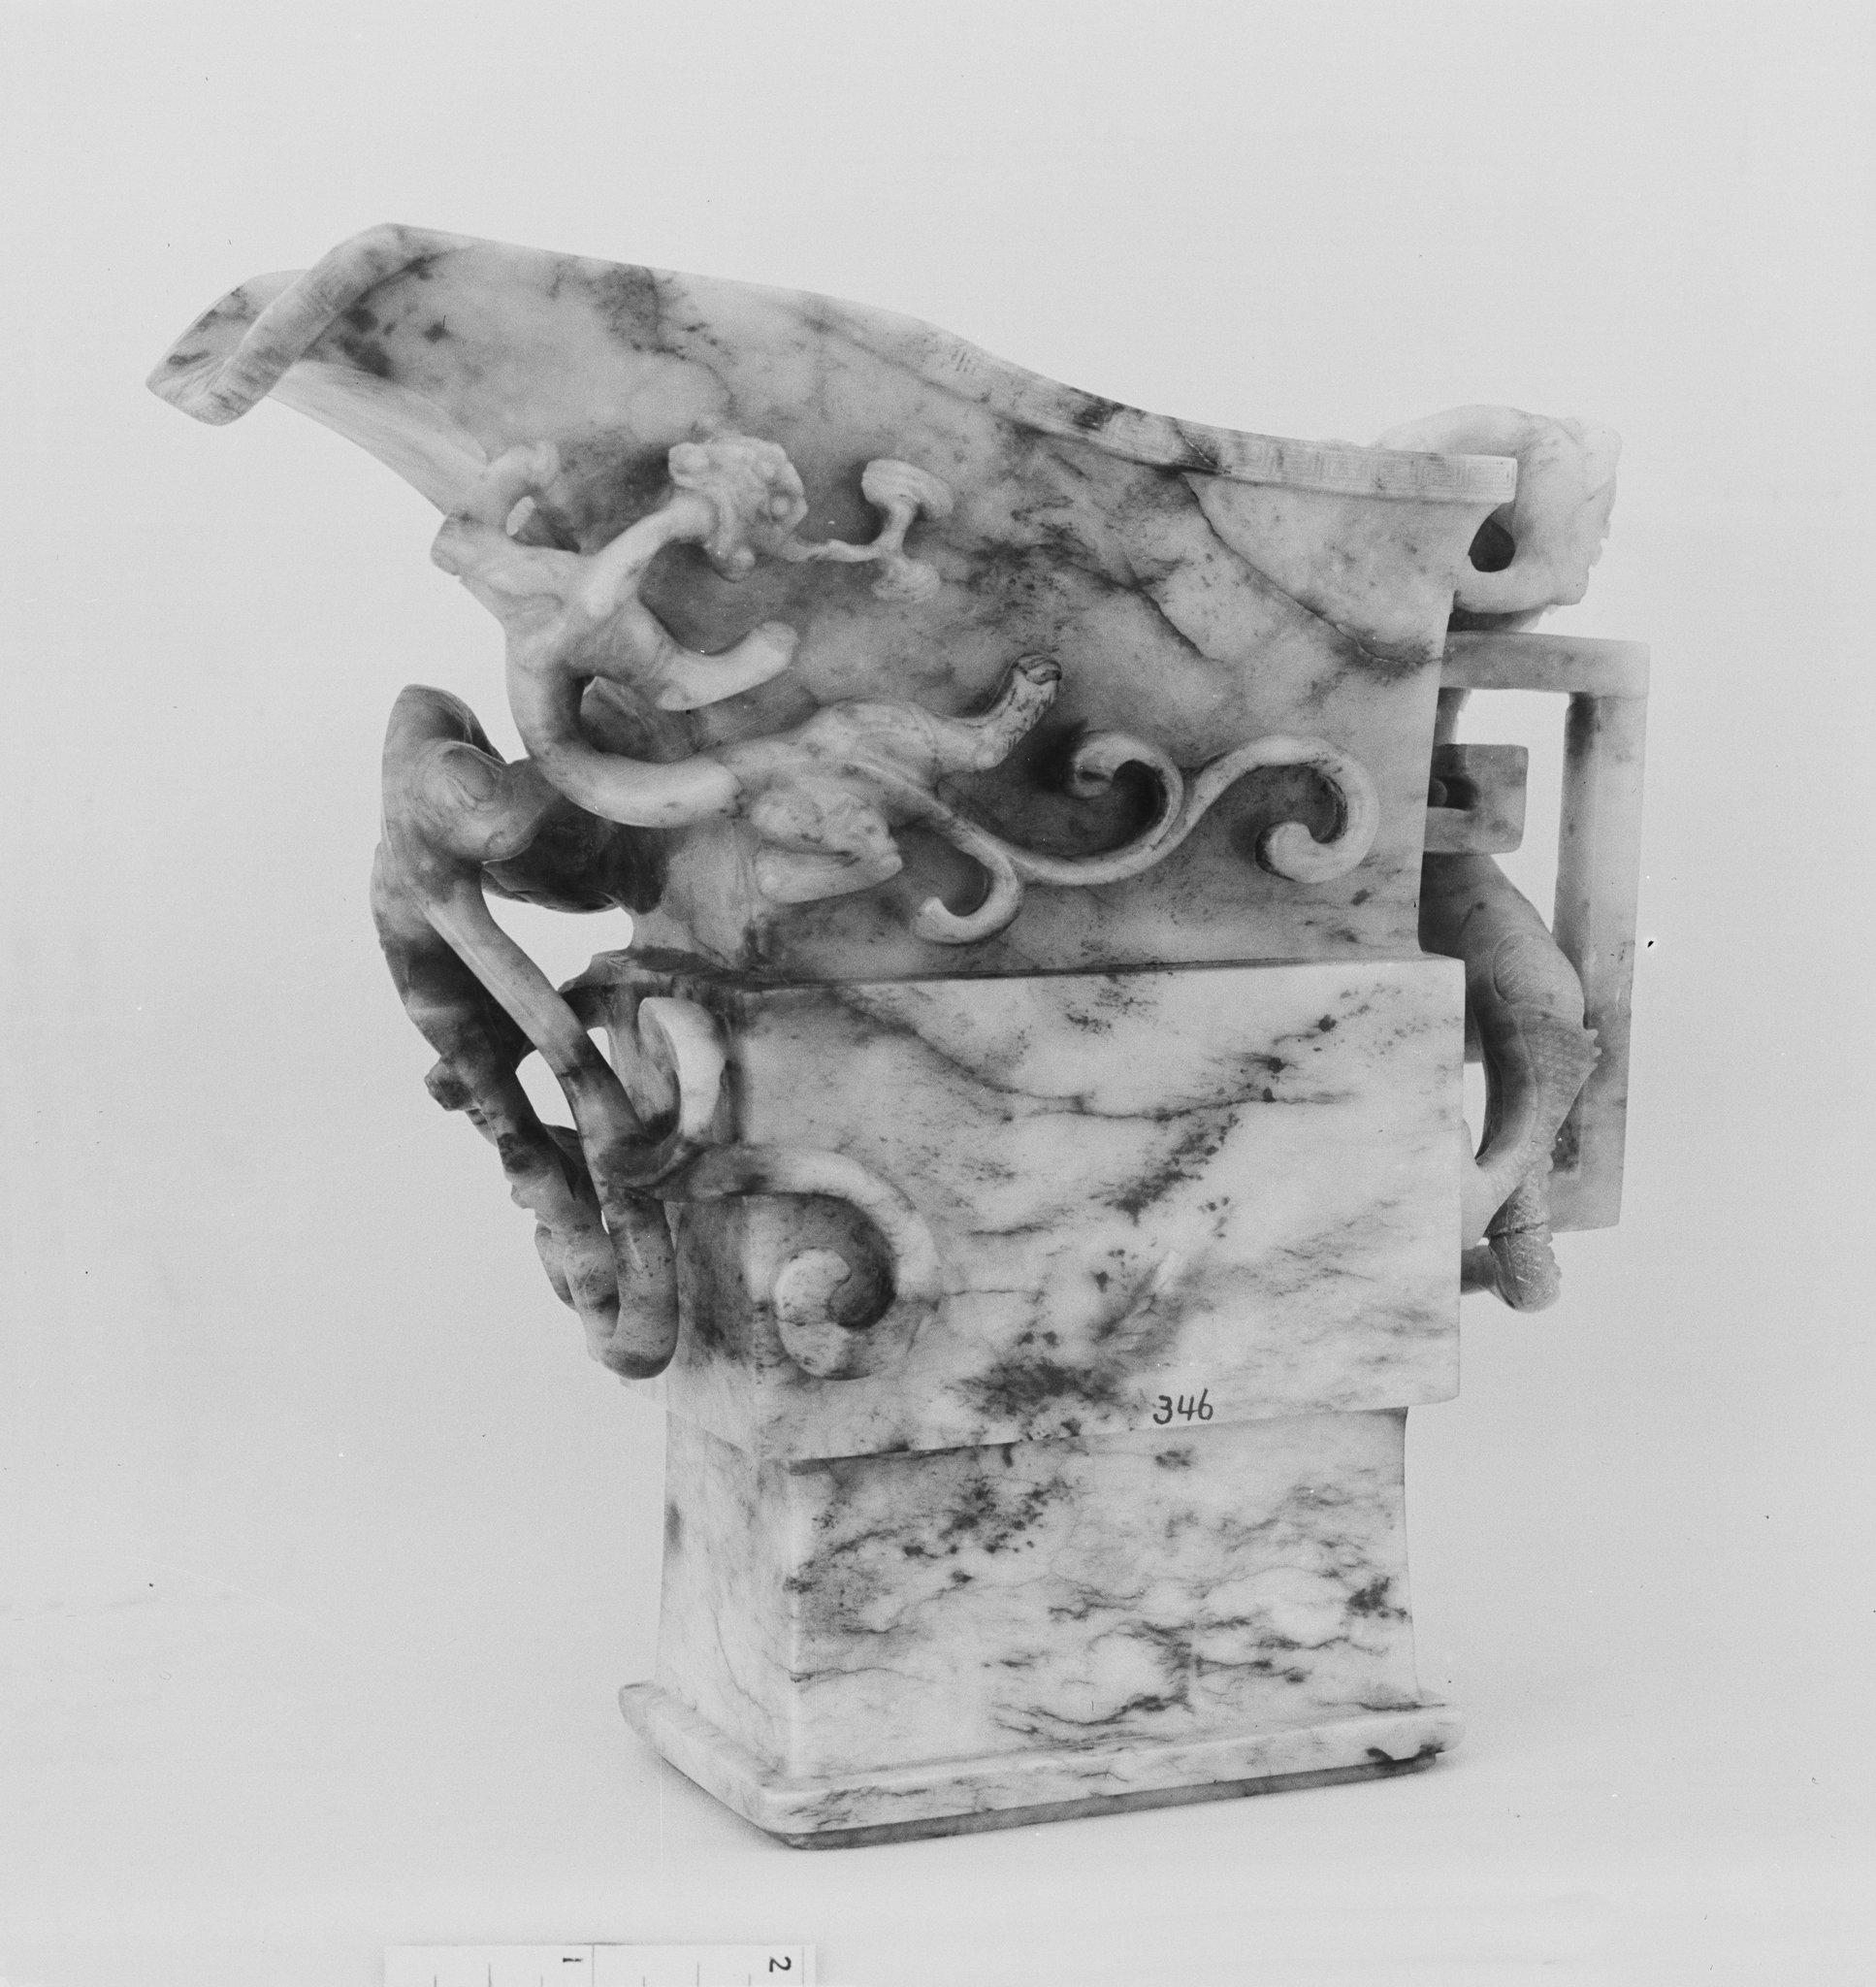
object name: vessel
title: Sacrificial Vessel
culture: chinese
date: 1368-1644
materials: jade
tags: dragons